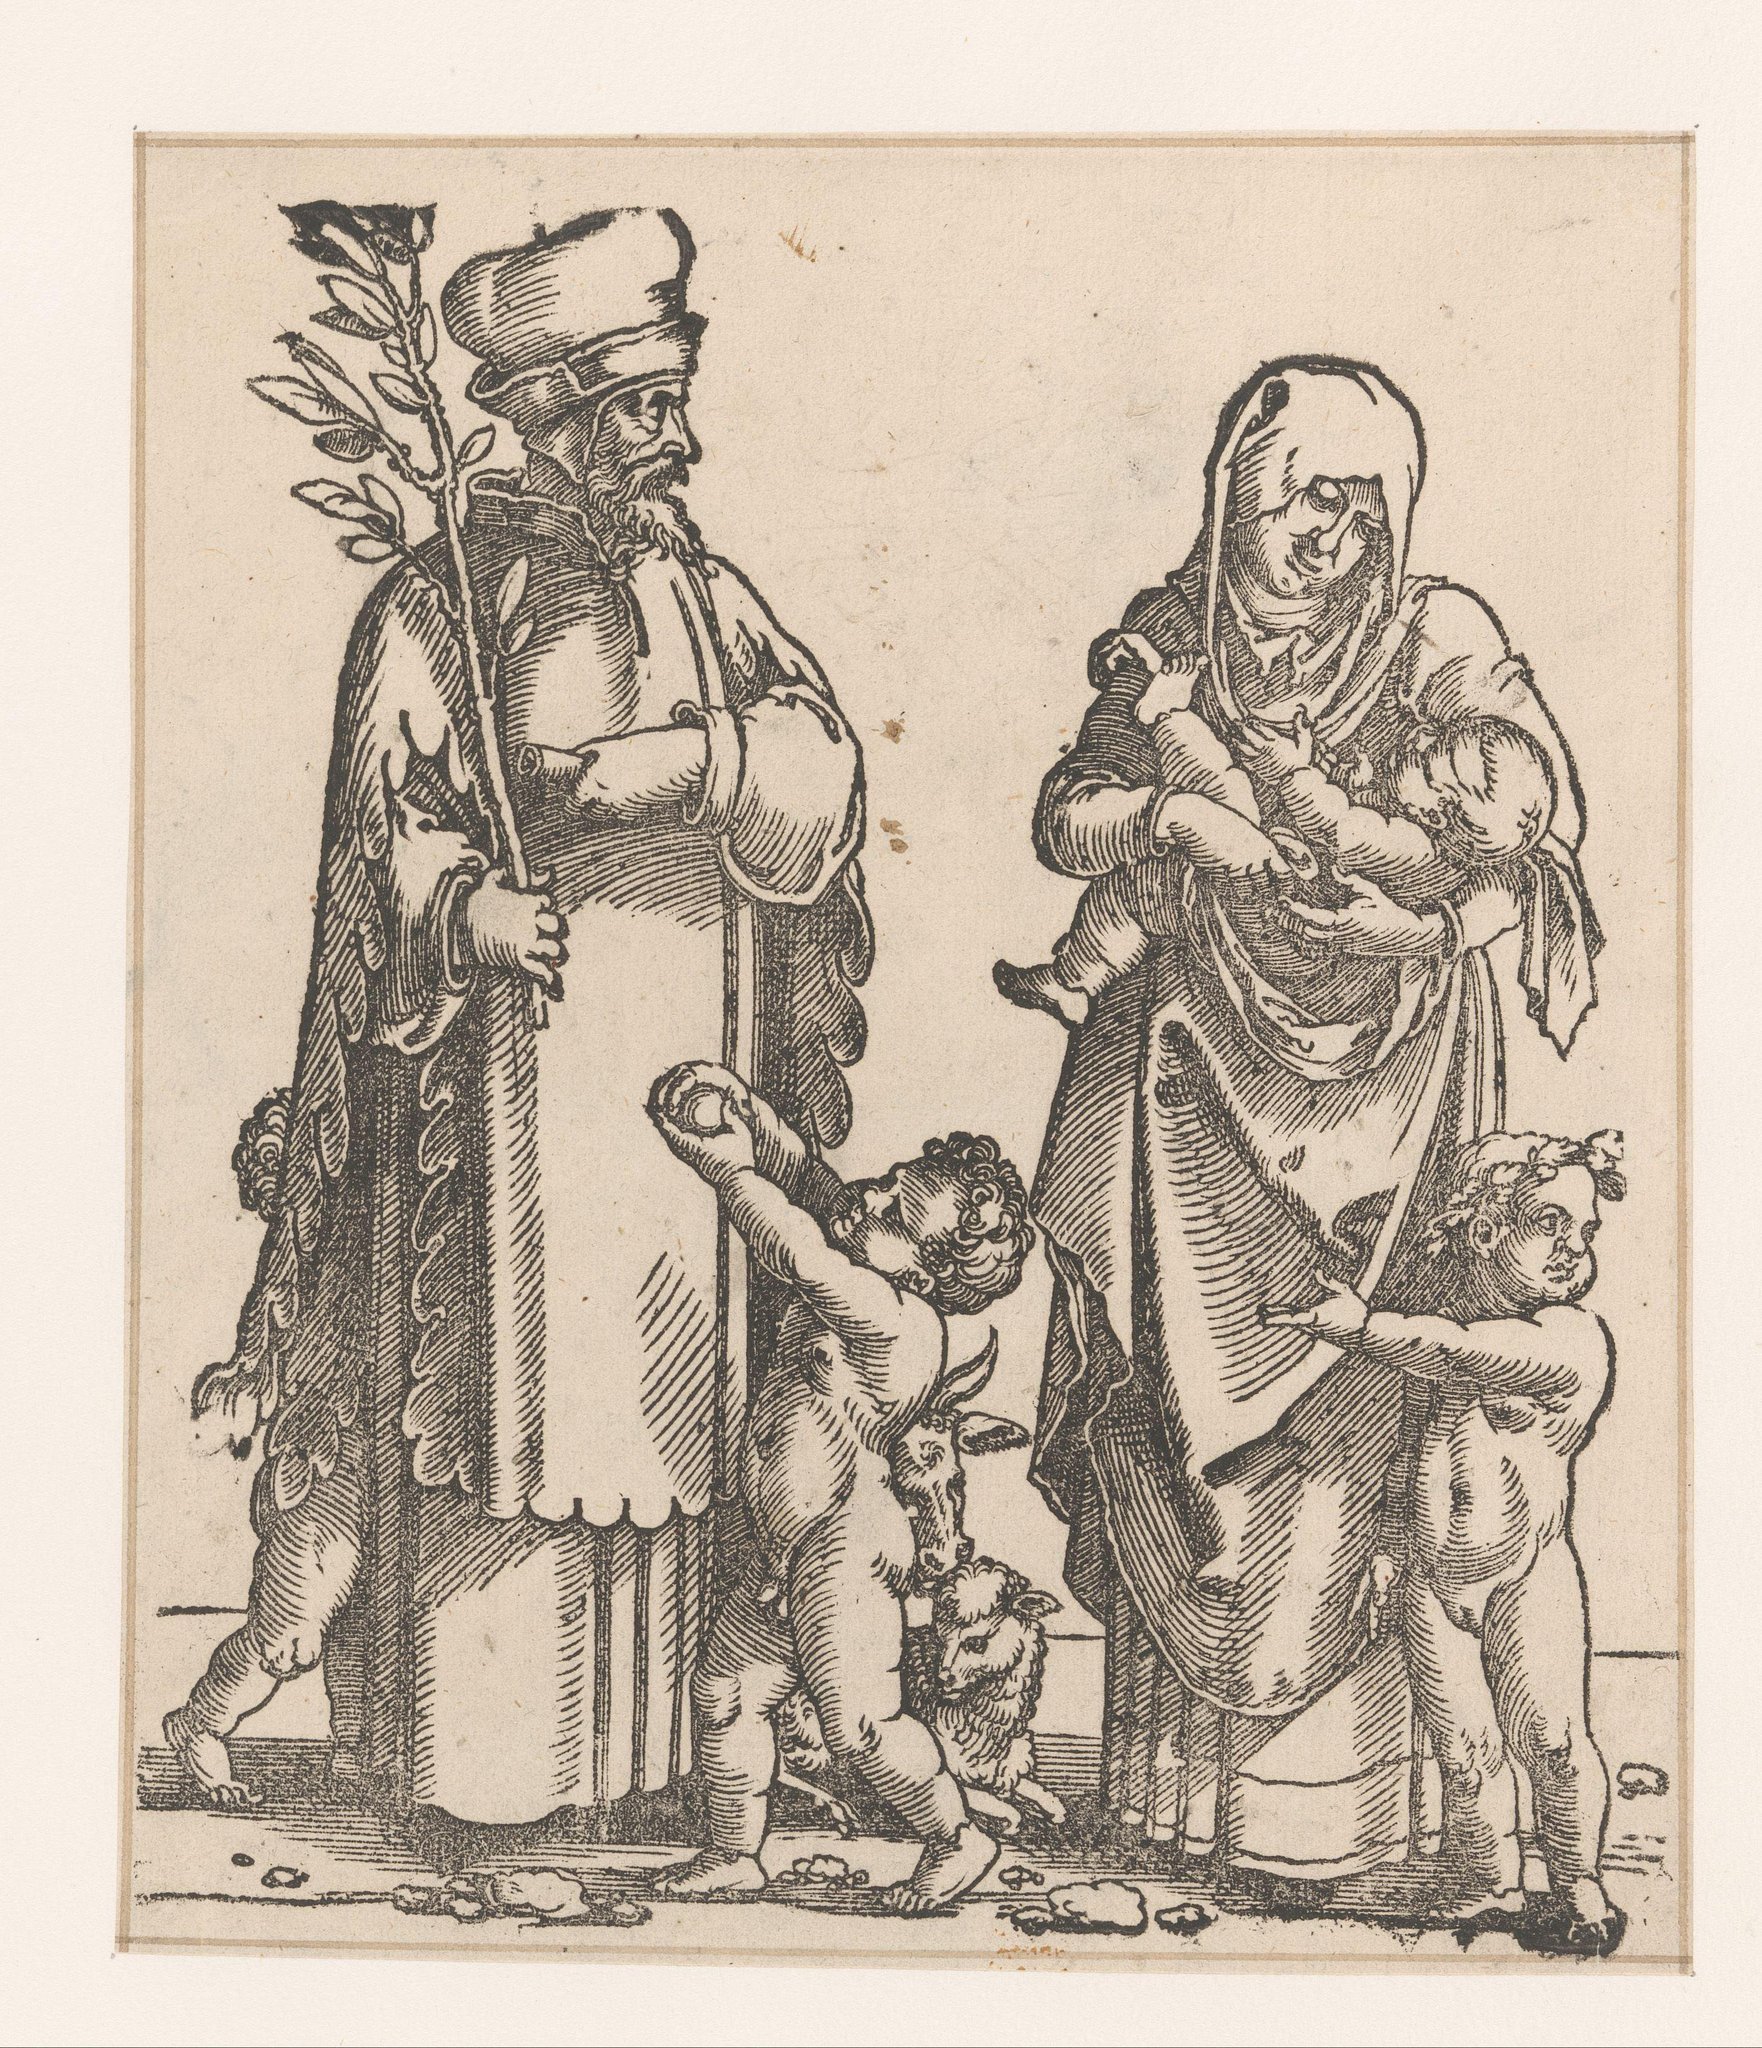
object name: print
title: Patriarchen van het Oude Testament met hun vrouwen en kinderen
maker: Anonymous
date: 1530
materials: paper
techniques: woodcut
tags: male persons from the old testament (kenan) (kenan)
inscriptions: collector's mark: Lugt 240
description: Onderdeel van een serie van tien houtsnedes met de patriarchen.